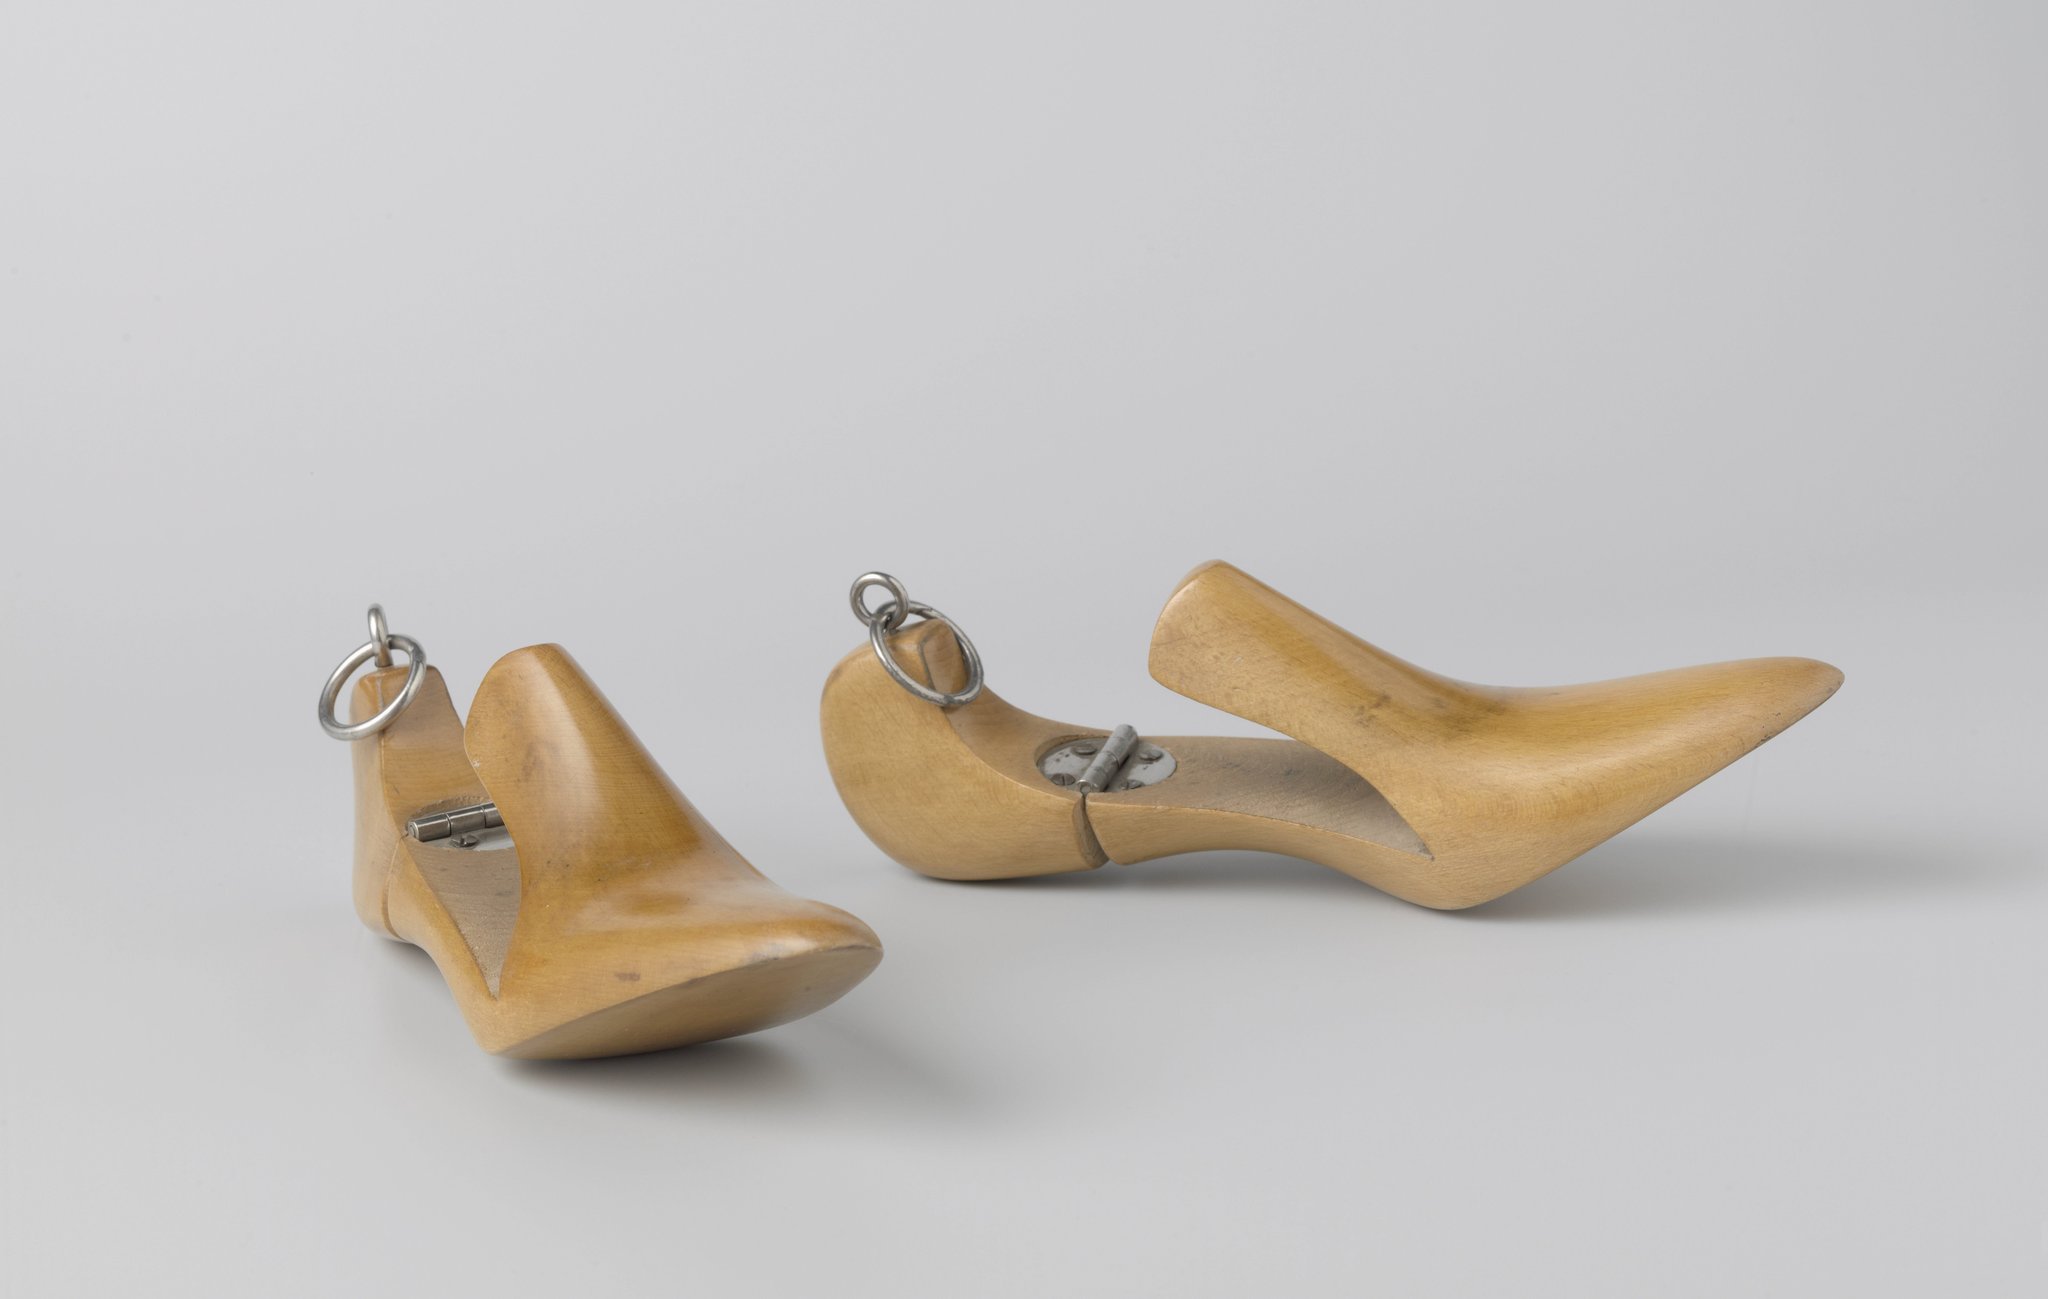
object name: womenswear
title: Spanleest van hout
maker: Anonymous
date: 1950-1970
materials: metal, wood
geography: western europe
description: Rechterspanleest van hout met metalen scharnier en ring. Behorend bij pump van donkerblauw suède versierd met donkerblauw slangenleer.